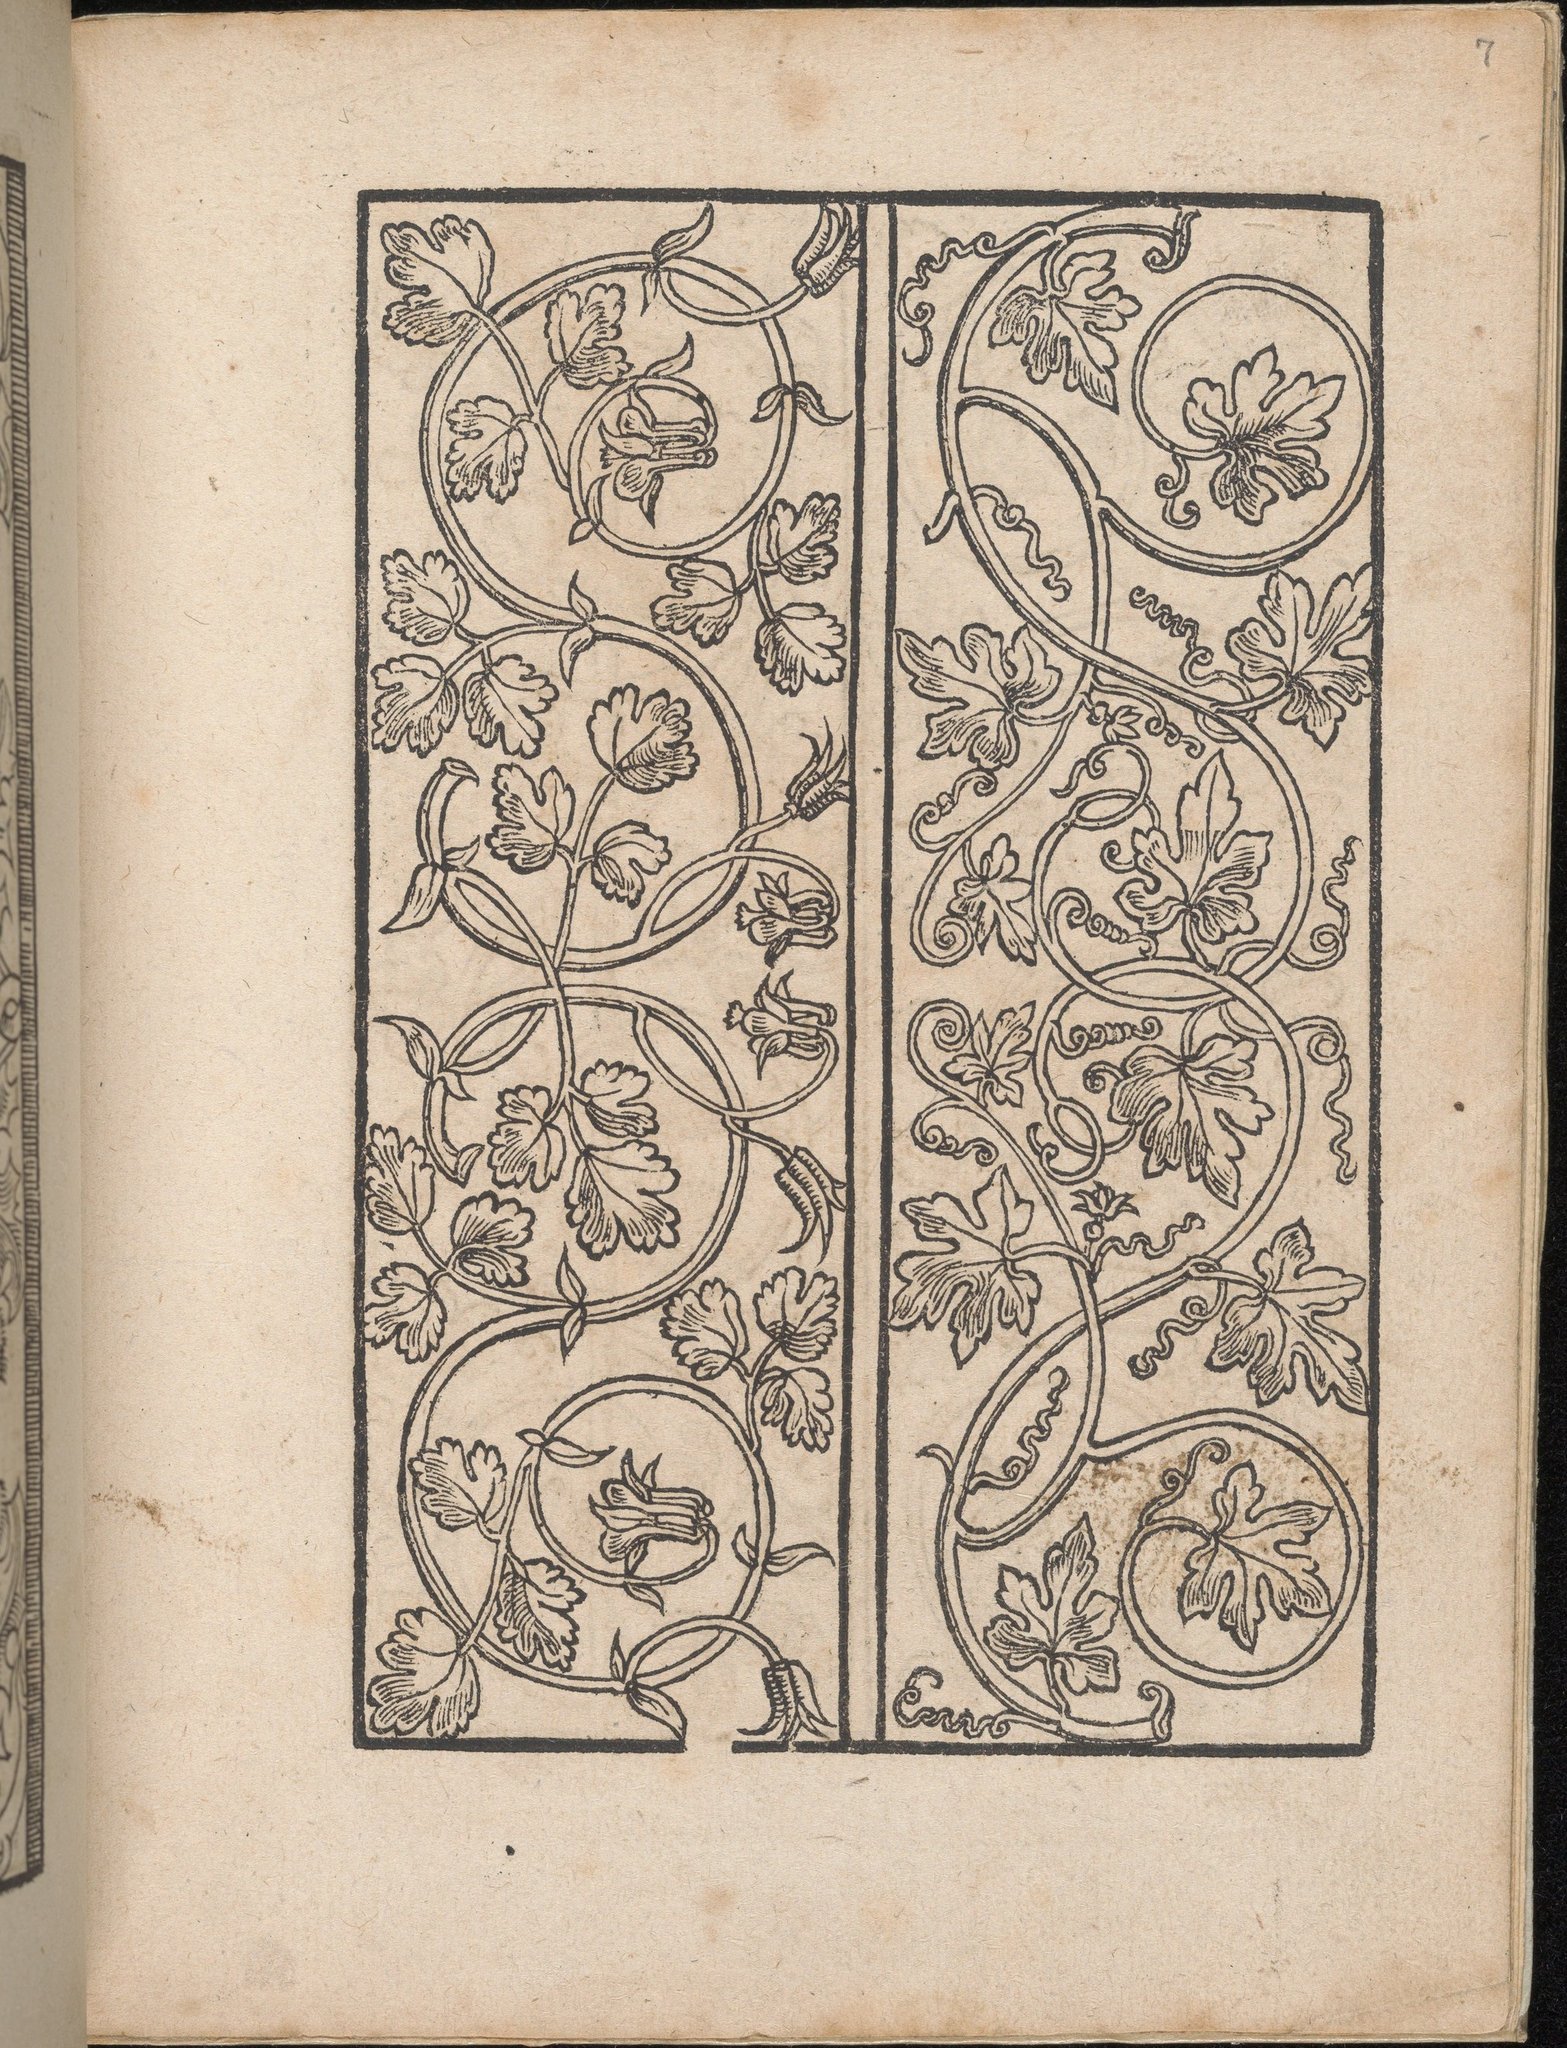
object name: book print ornament architecture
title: Ein new Modelbuch..., page 4 (recto)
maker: johann schönsperger the younger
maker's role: publisher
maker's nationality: german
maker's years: 1490-1550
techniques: woodcut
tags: acanthus